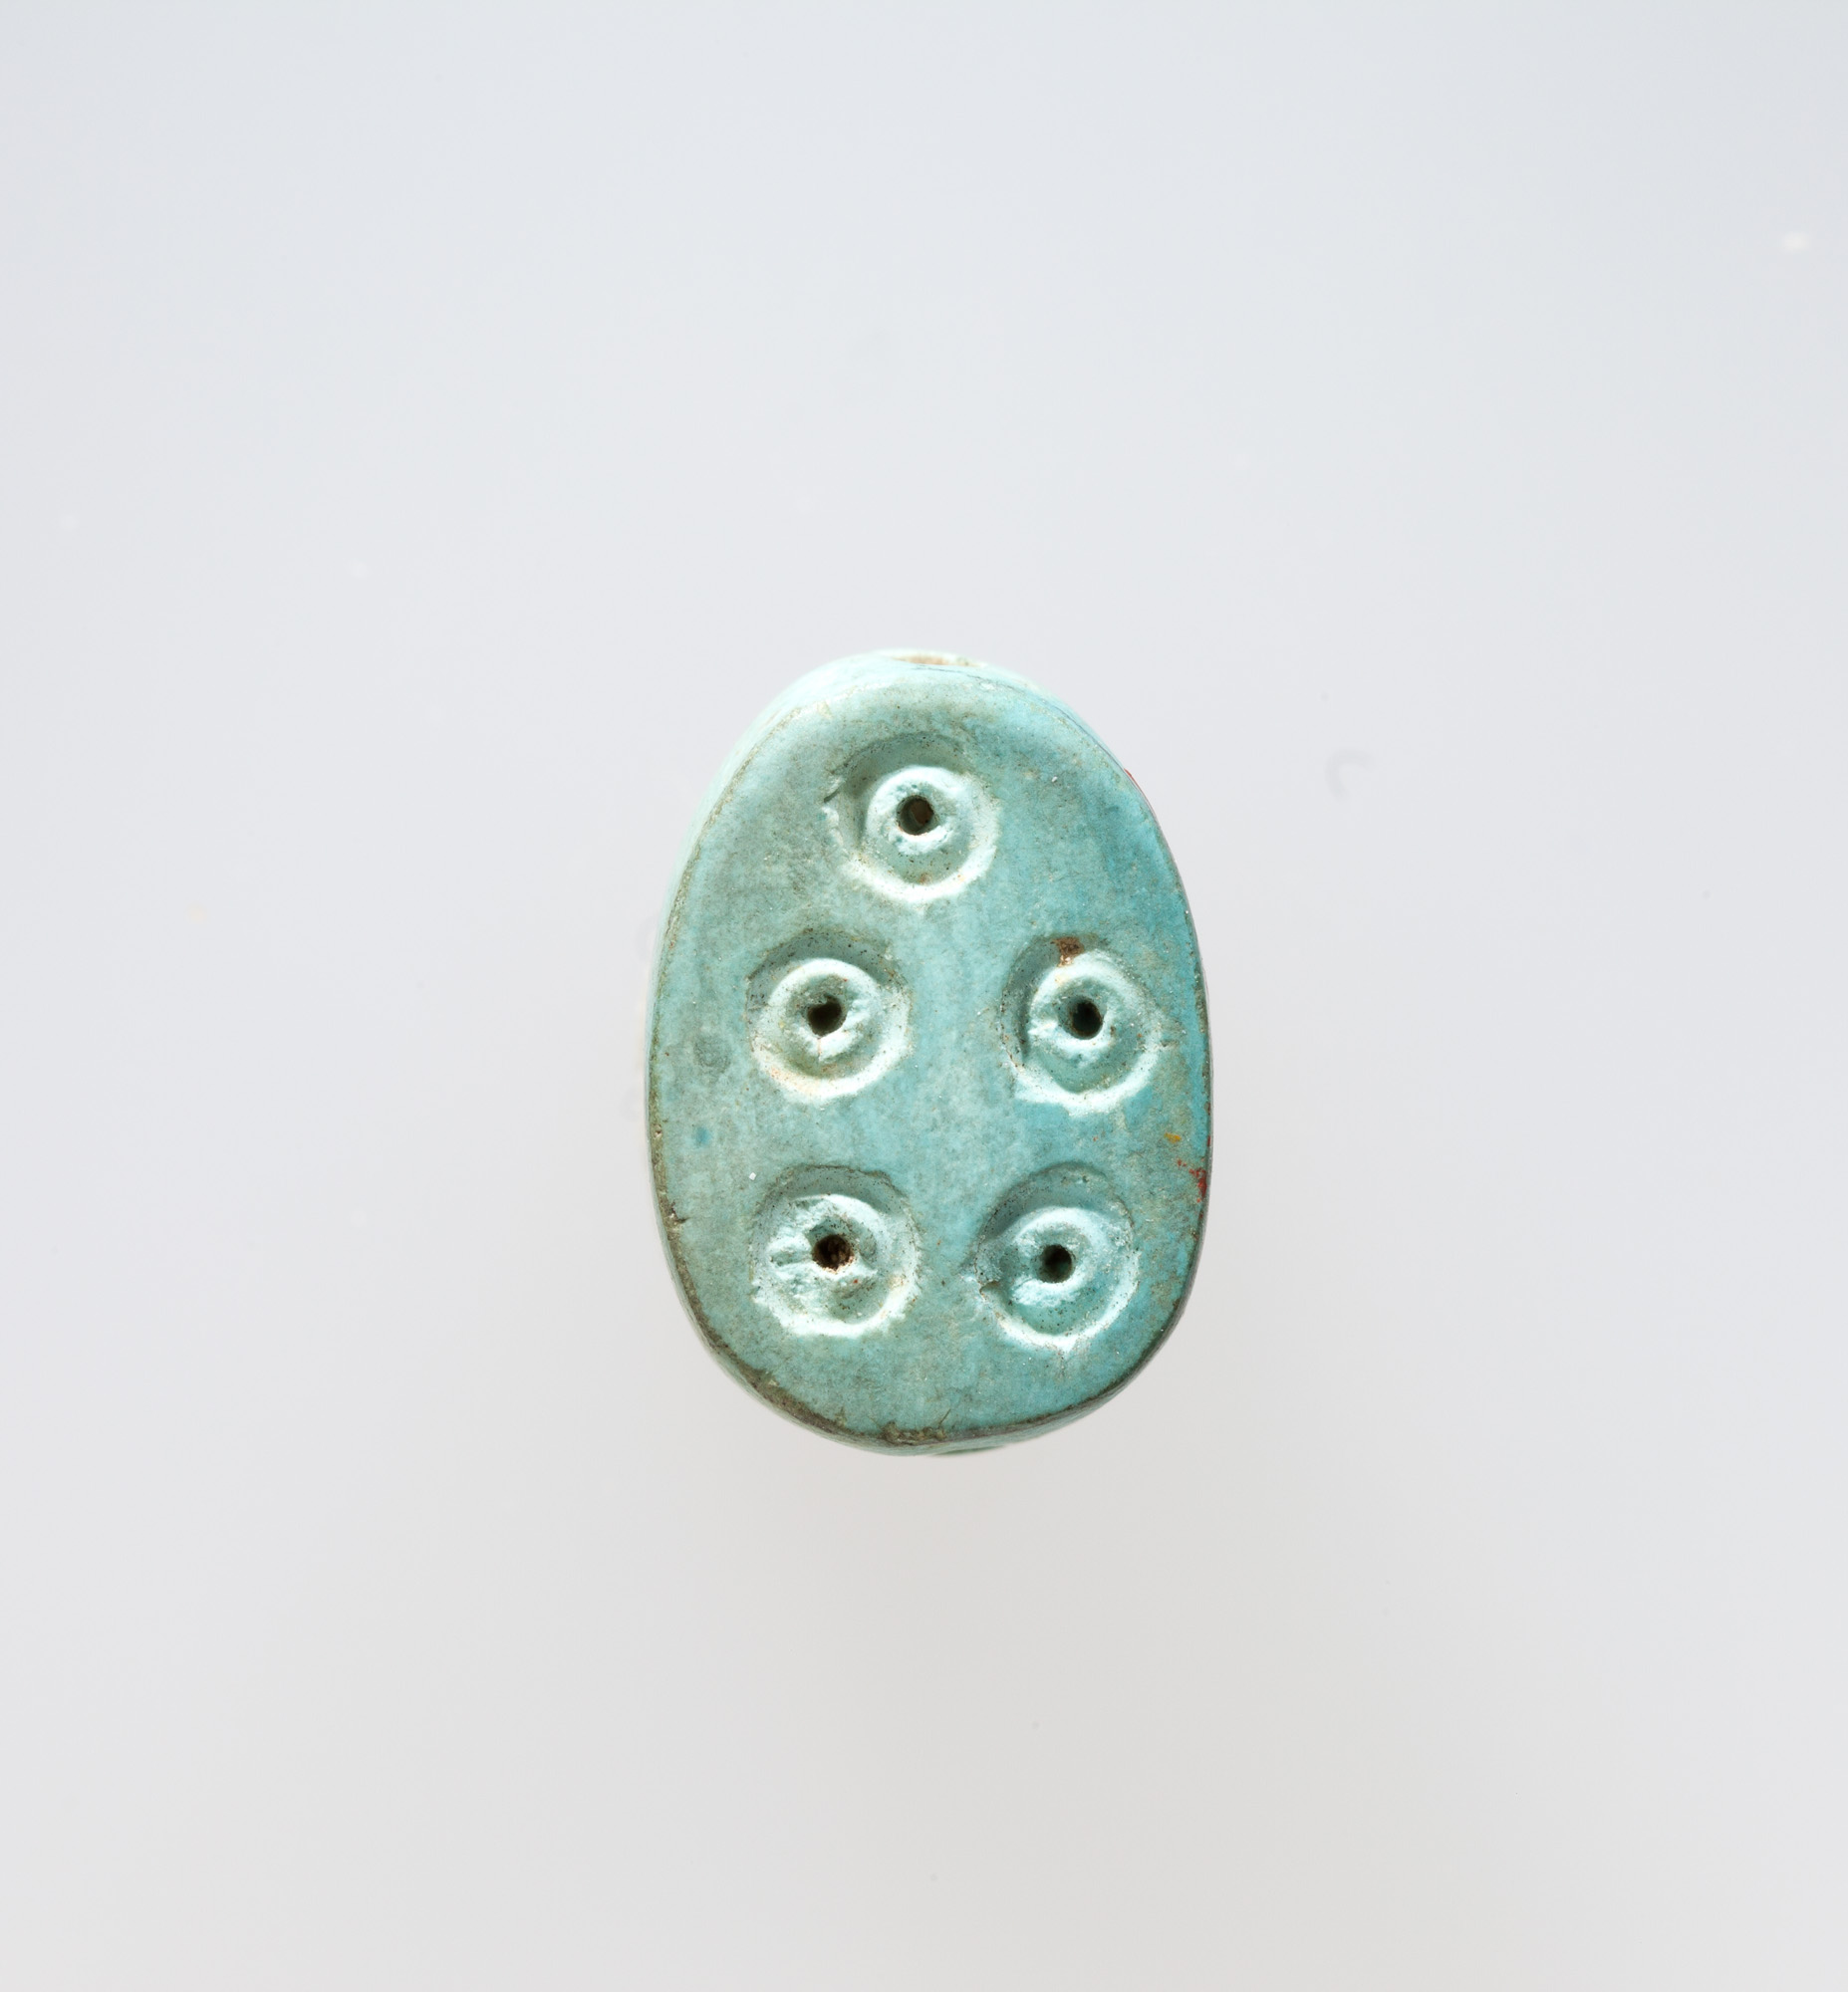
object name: scarab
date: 1479-1458 BCE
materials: faience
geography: egypt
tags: scarabs